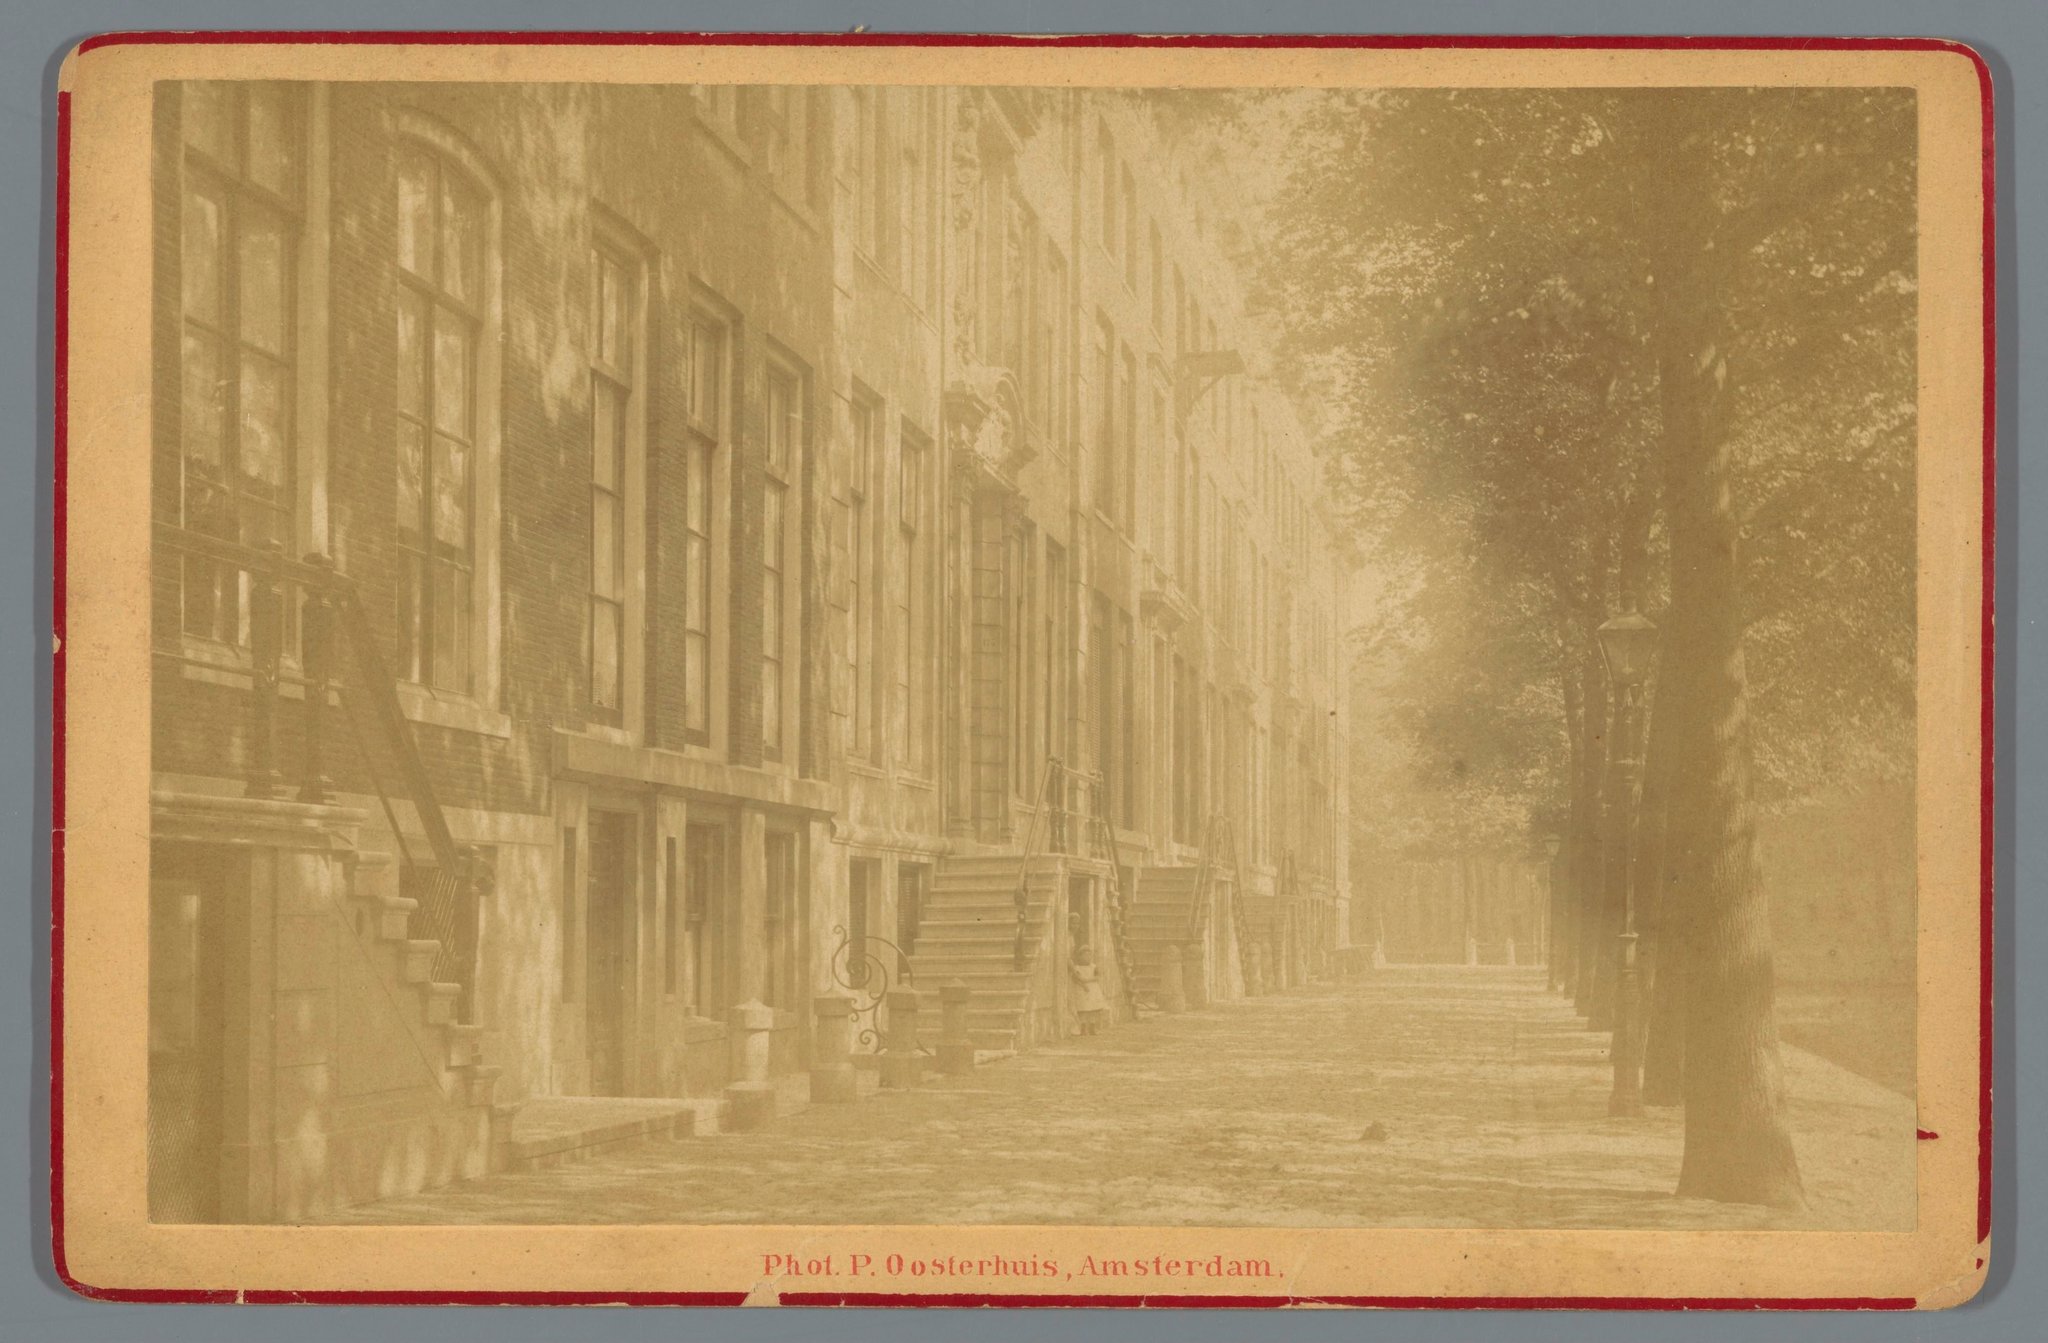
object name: cabinet photograph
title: Huizen aan de Herengracht, nummers 471 tot 475, Amsterdam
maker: pieter oosterhuis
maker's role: draughtsman, print maker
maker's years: 1816-1885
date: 1867-1885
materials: cardboard, paper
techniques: albumen print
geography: amsterdam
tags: street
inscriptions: inscription: ‘4,-’, inscription: ‘Phot. P. Oosterhuis, Amsterdam.’